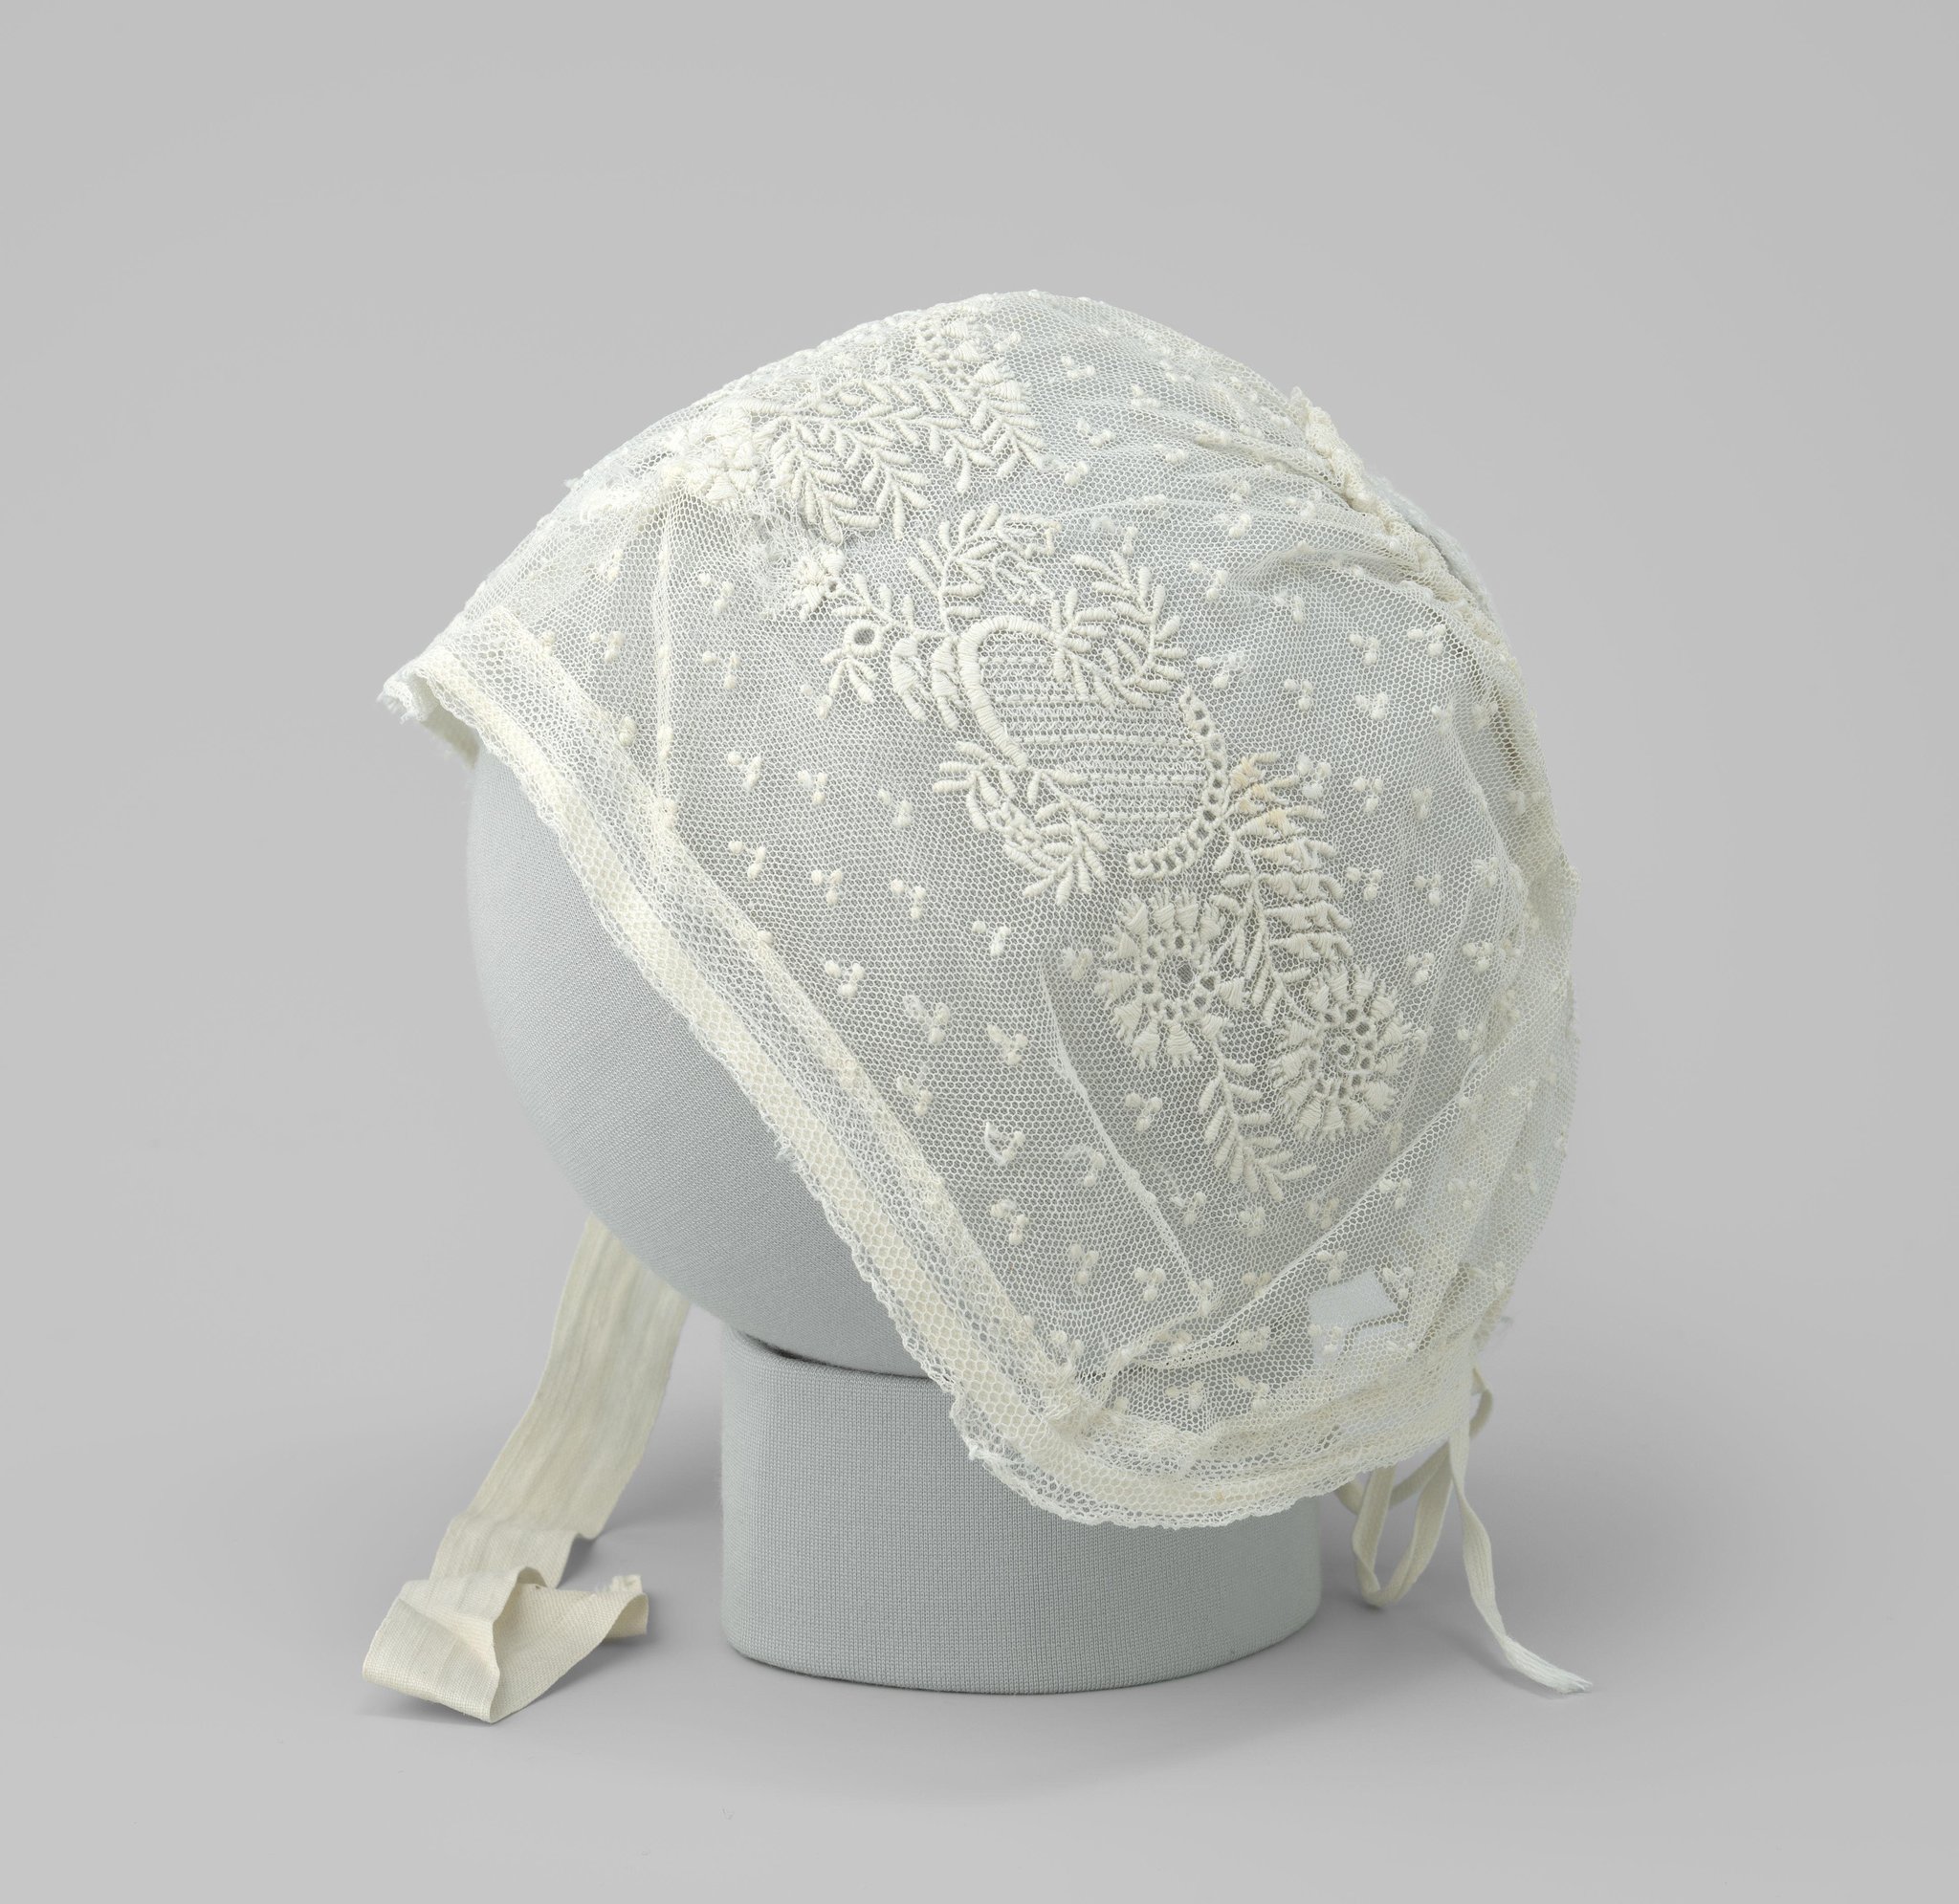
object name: babymuts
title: Babymuts van witte tule met wit borduurwerk en twee strikken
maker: Anonymous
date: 1800-1900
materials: lace, fiber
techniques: embroidered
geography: netherlands